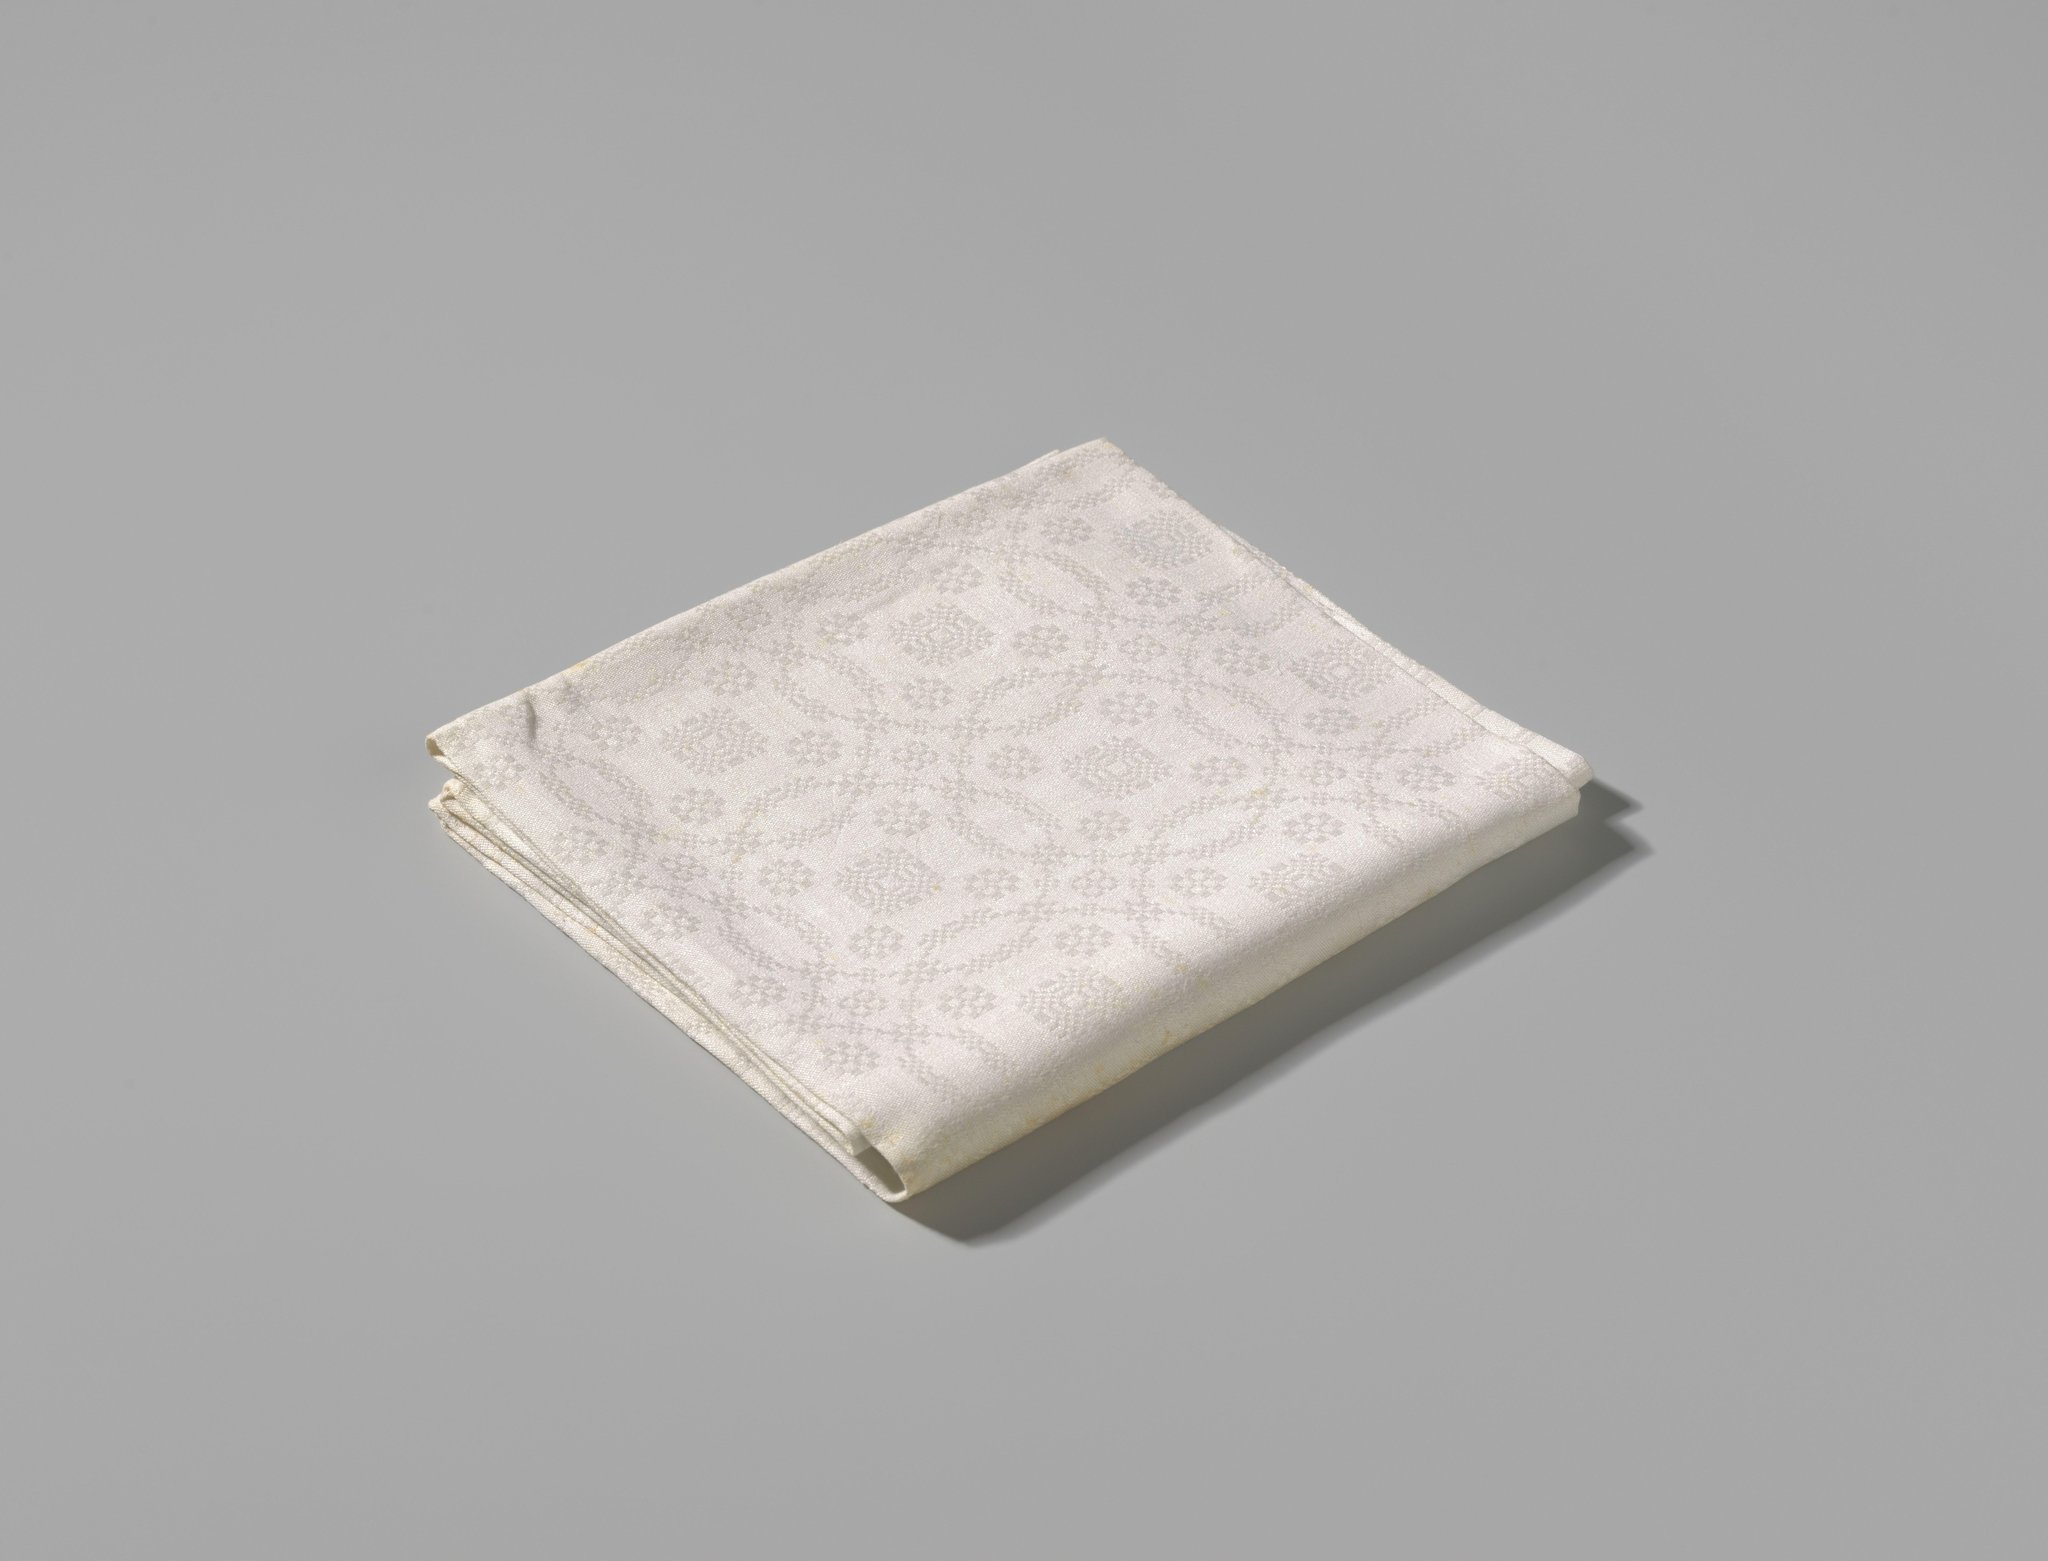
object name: towel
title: Handdwaal van pellendamast.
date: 1675-1700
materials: linen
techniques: weave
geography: netherlands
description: Handdwaal van pellendamast. Het patroon heeft elkaar snijdende cirkels waarbinnen vijf geblokte rozetten. De dwaal is gemerkt: KS 93.